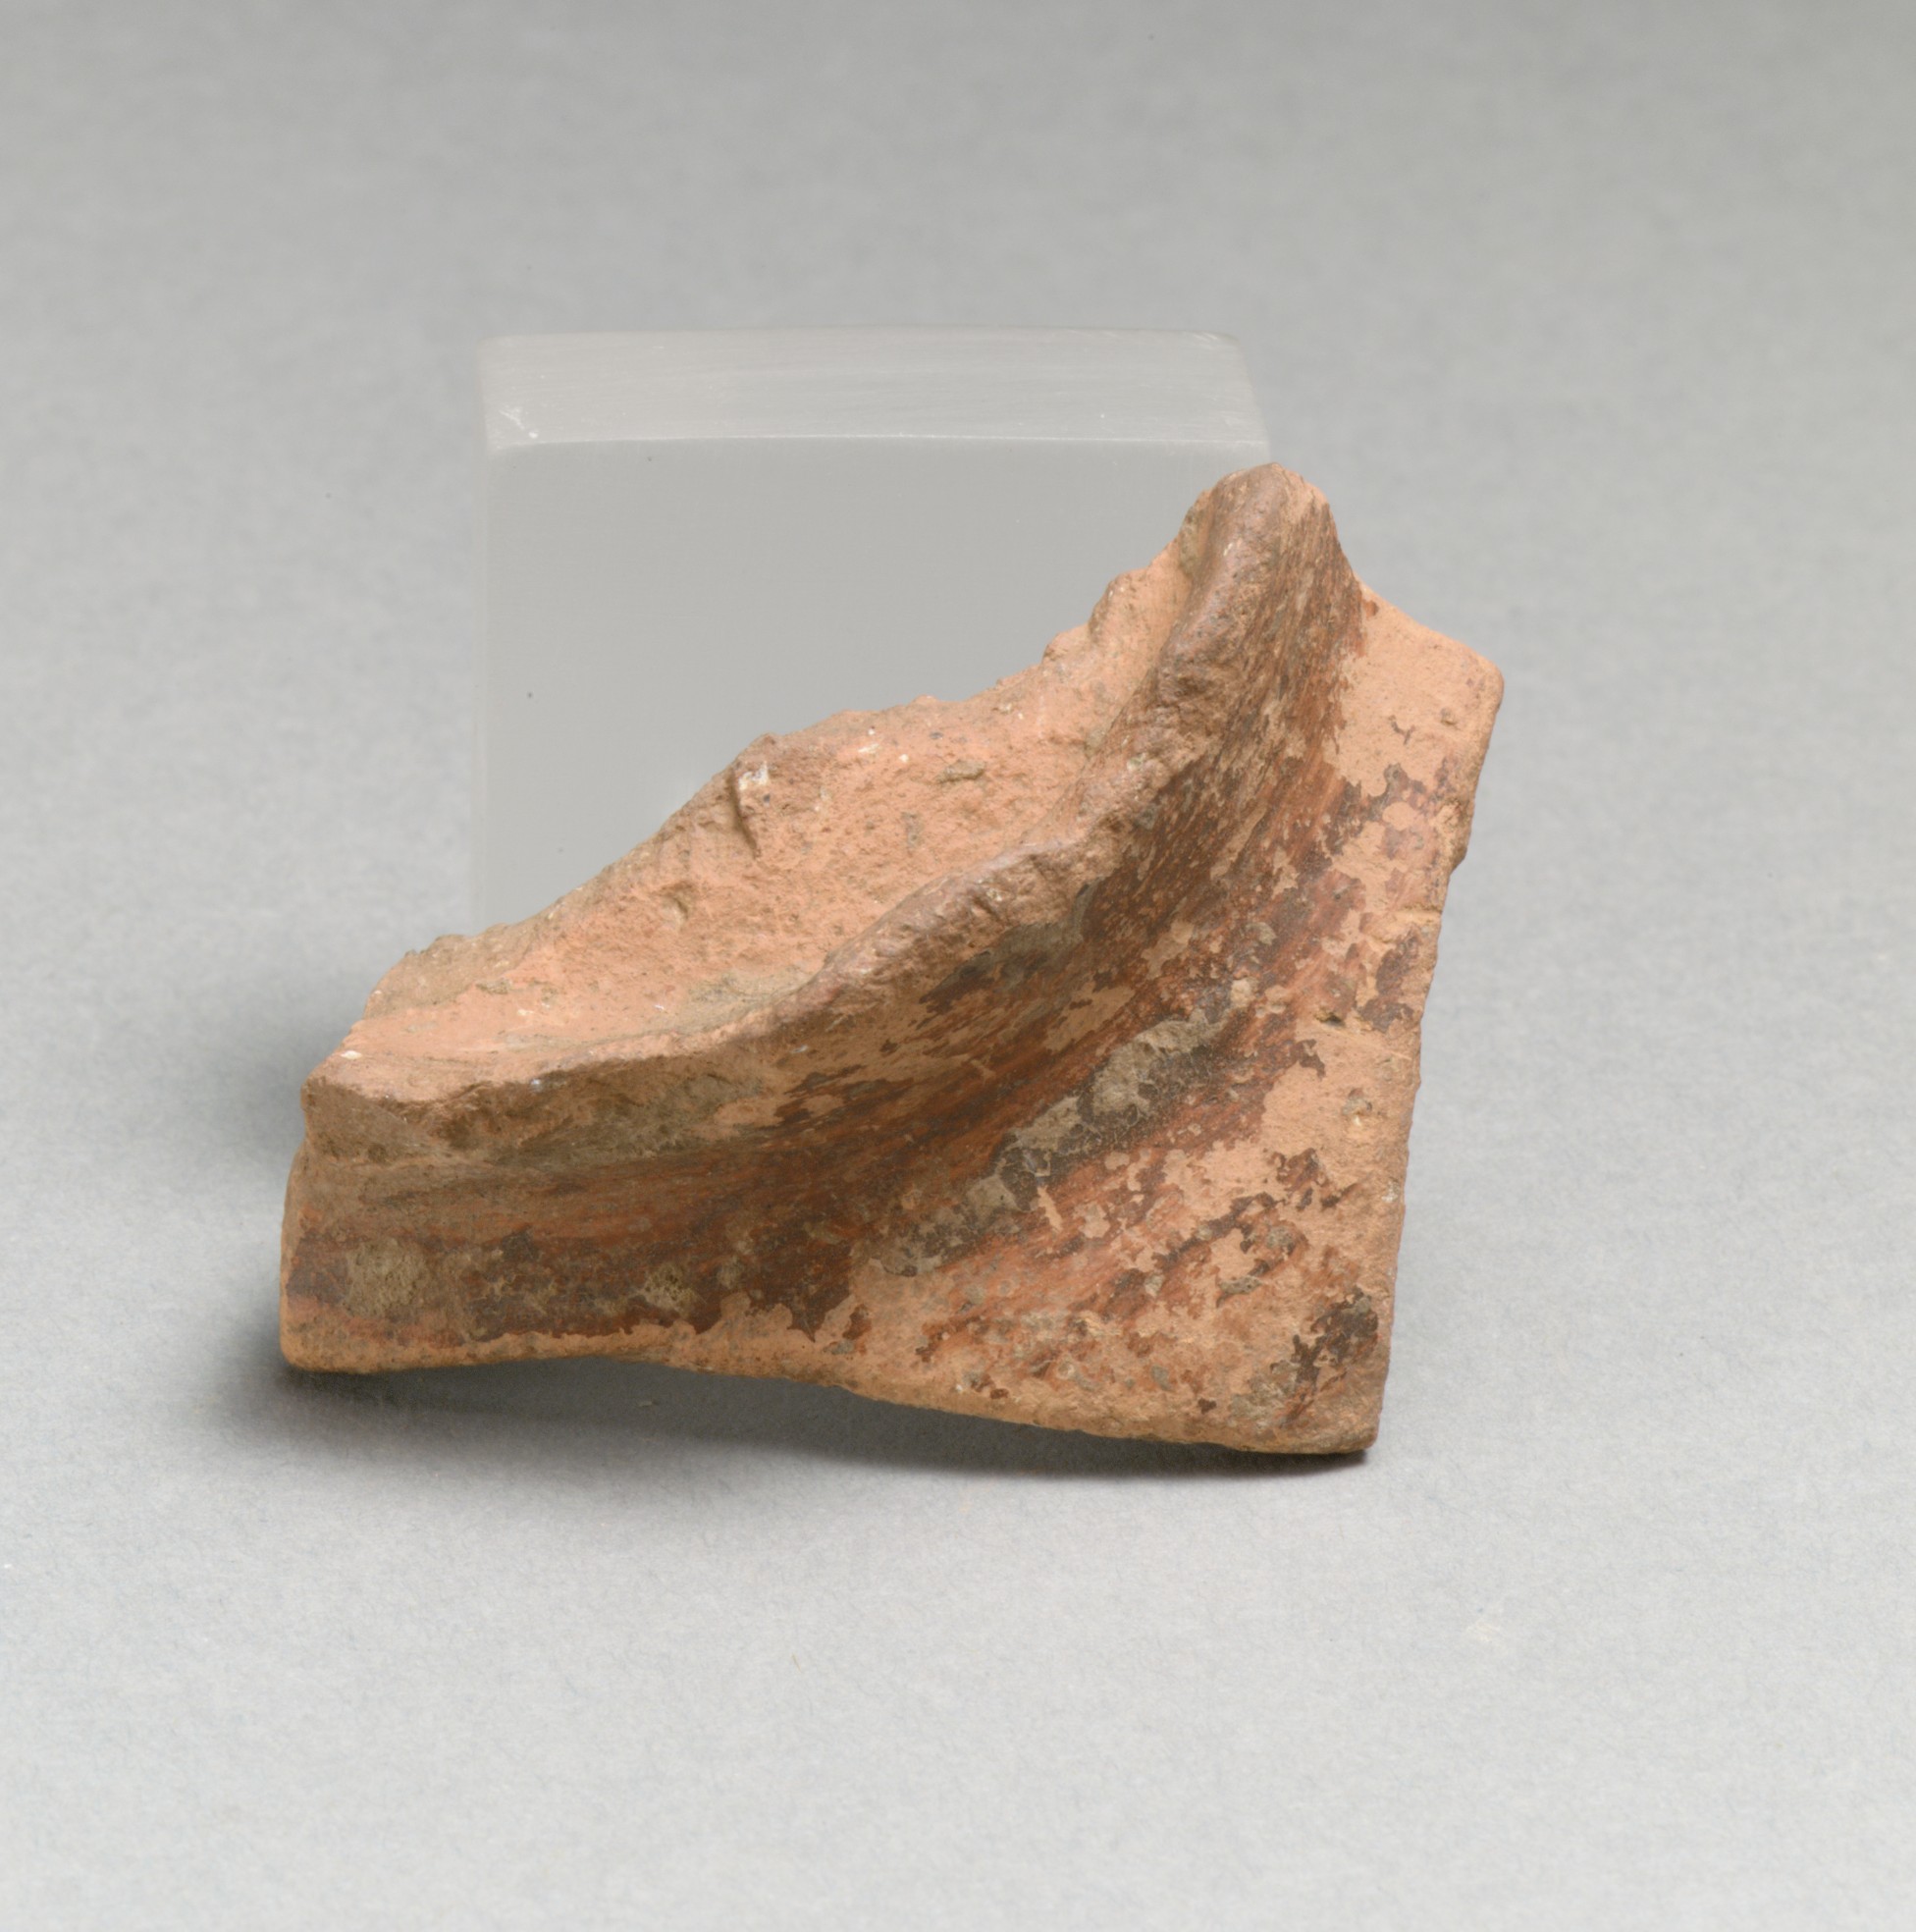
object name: vase fragment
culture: neolithic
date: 7000-3000 BCE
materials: terracotta